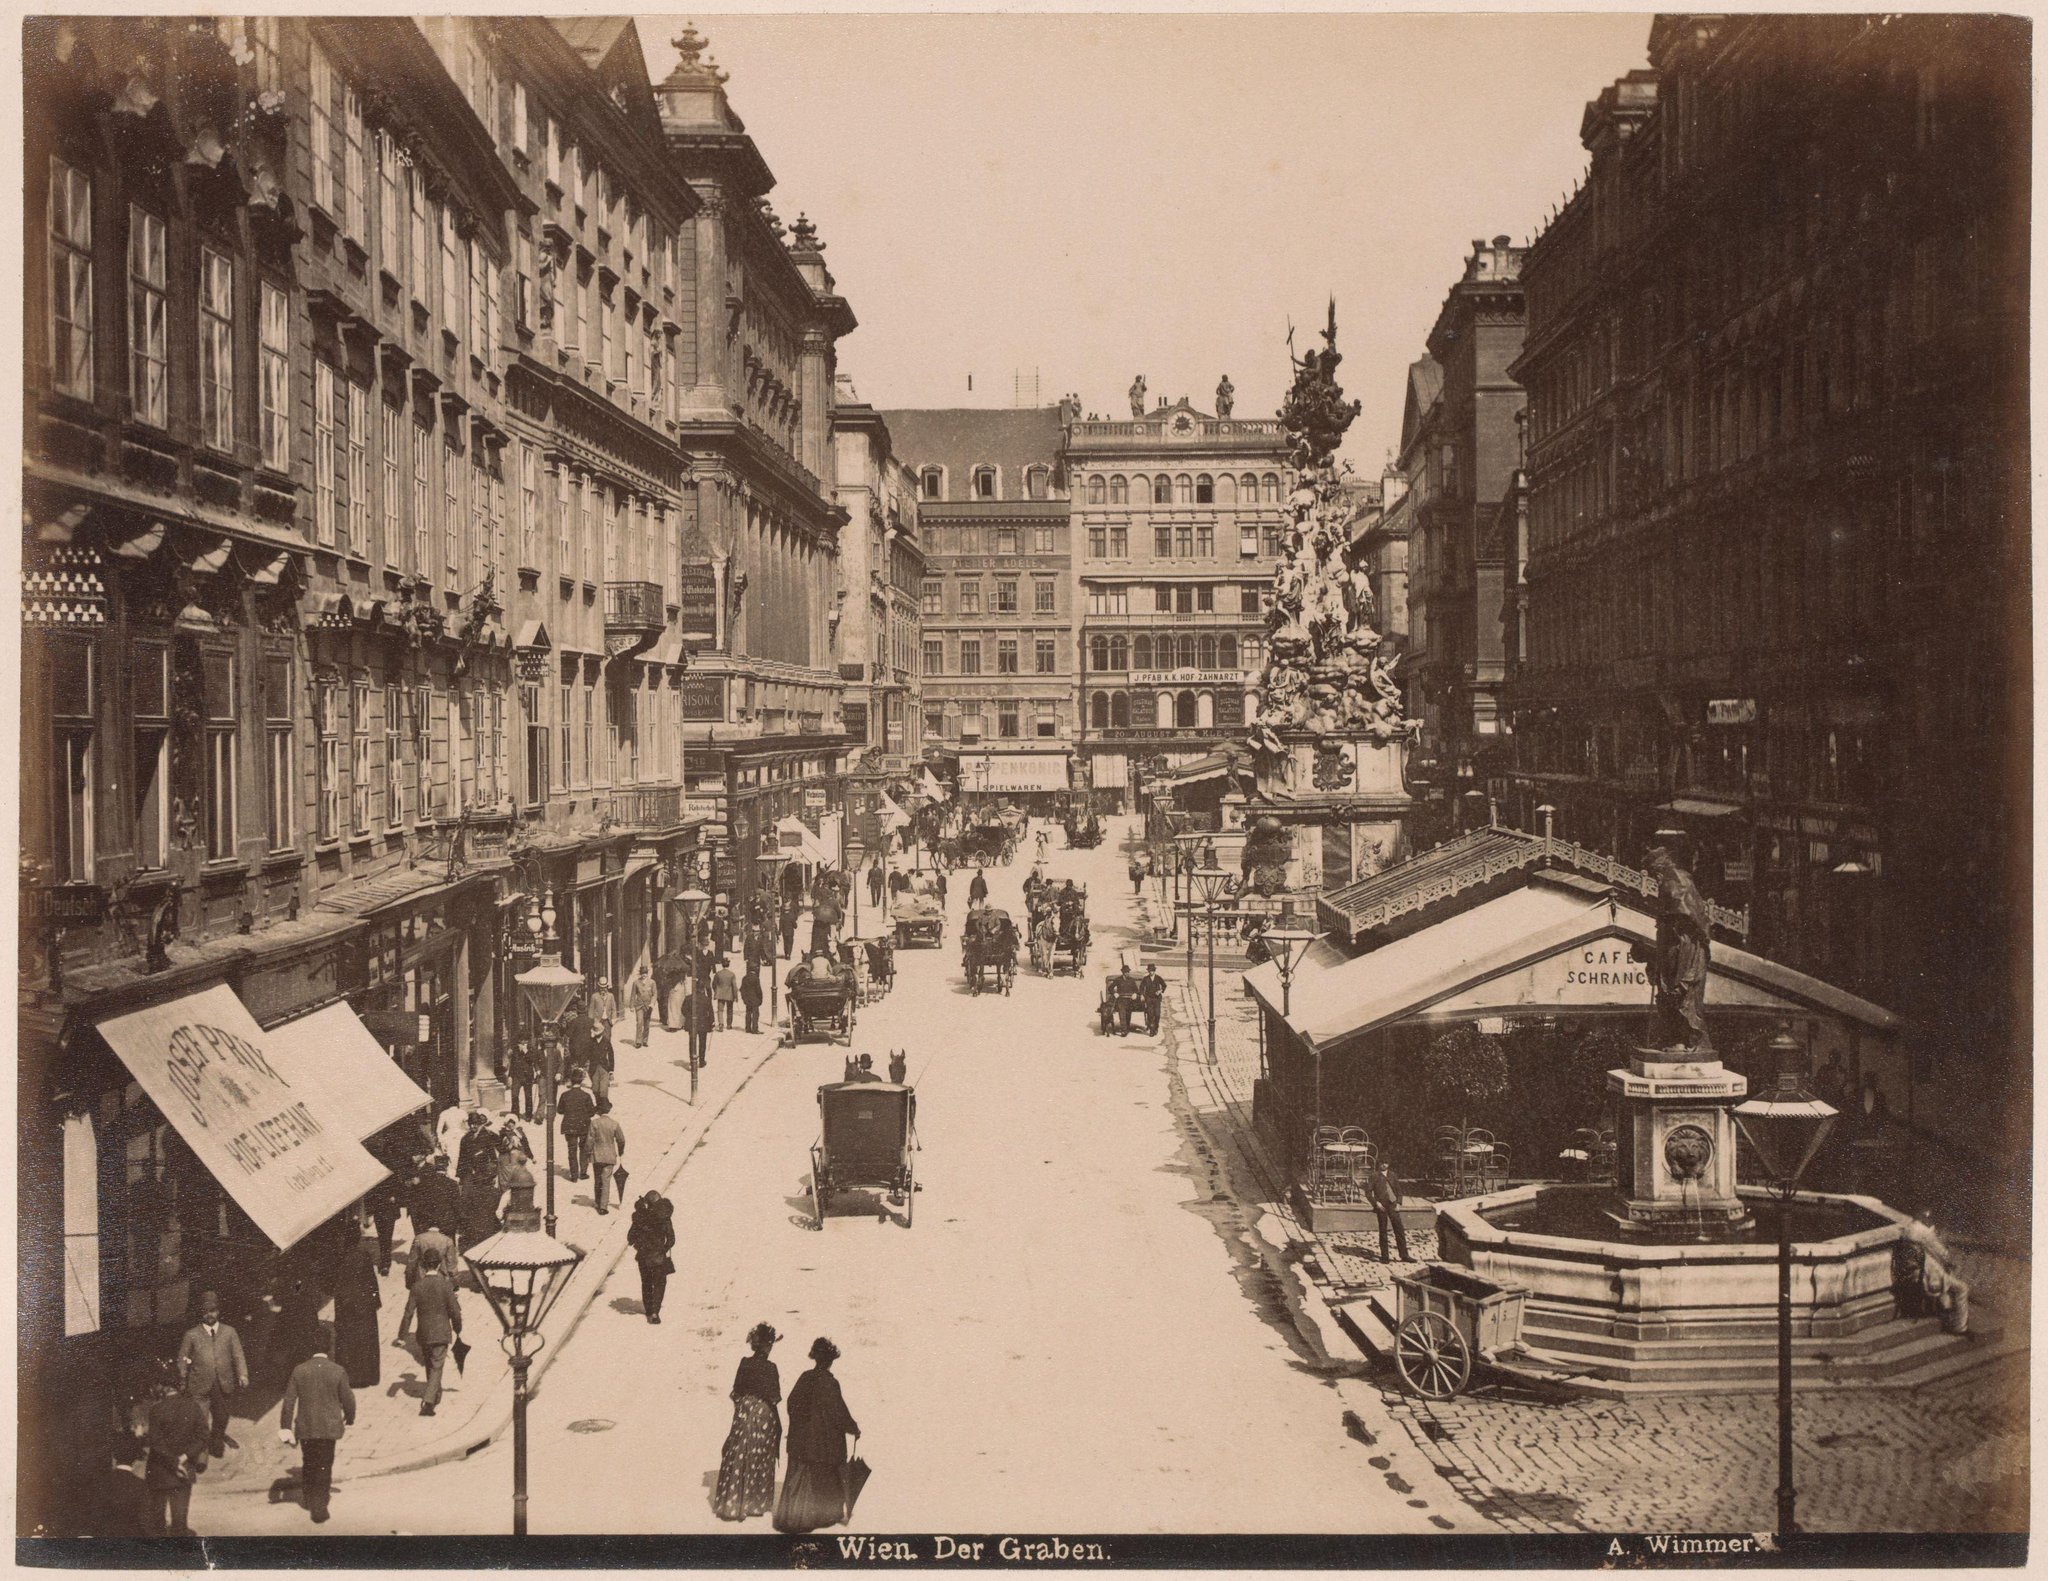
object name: photograph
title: Wien. Der Graben.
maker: a. wimmer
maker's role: fotograaf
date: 1880-1895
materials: paper, photographic support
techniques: albumen print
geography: vienna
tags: shop, store, animal traction, animal-drawn vehicle (carriage etc.), piece of sculpture, reproduction of a piece of sculpture (+ sculpture), monument, statue, utilitarian, public pump or water fountain, street (+ city(-scape) with figures, staffage), vienna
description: Onderdeel van Reisalbum met foto's van bezienswaardigheden in Duitsland en Oostenrijk en van kunstwerken.